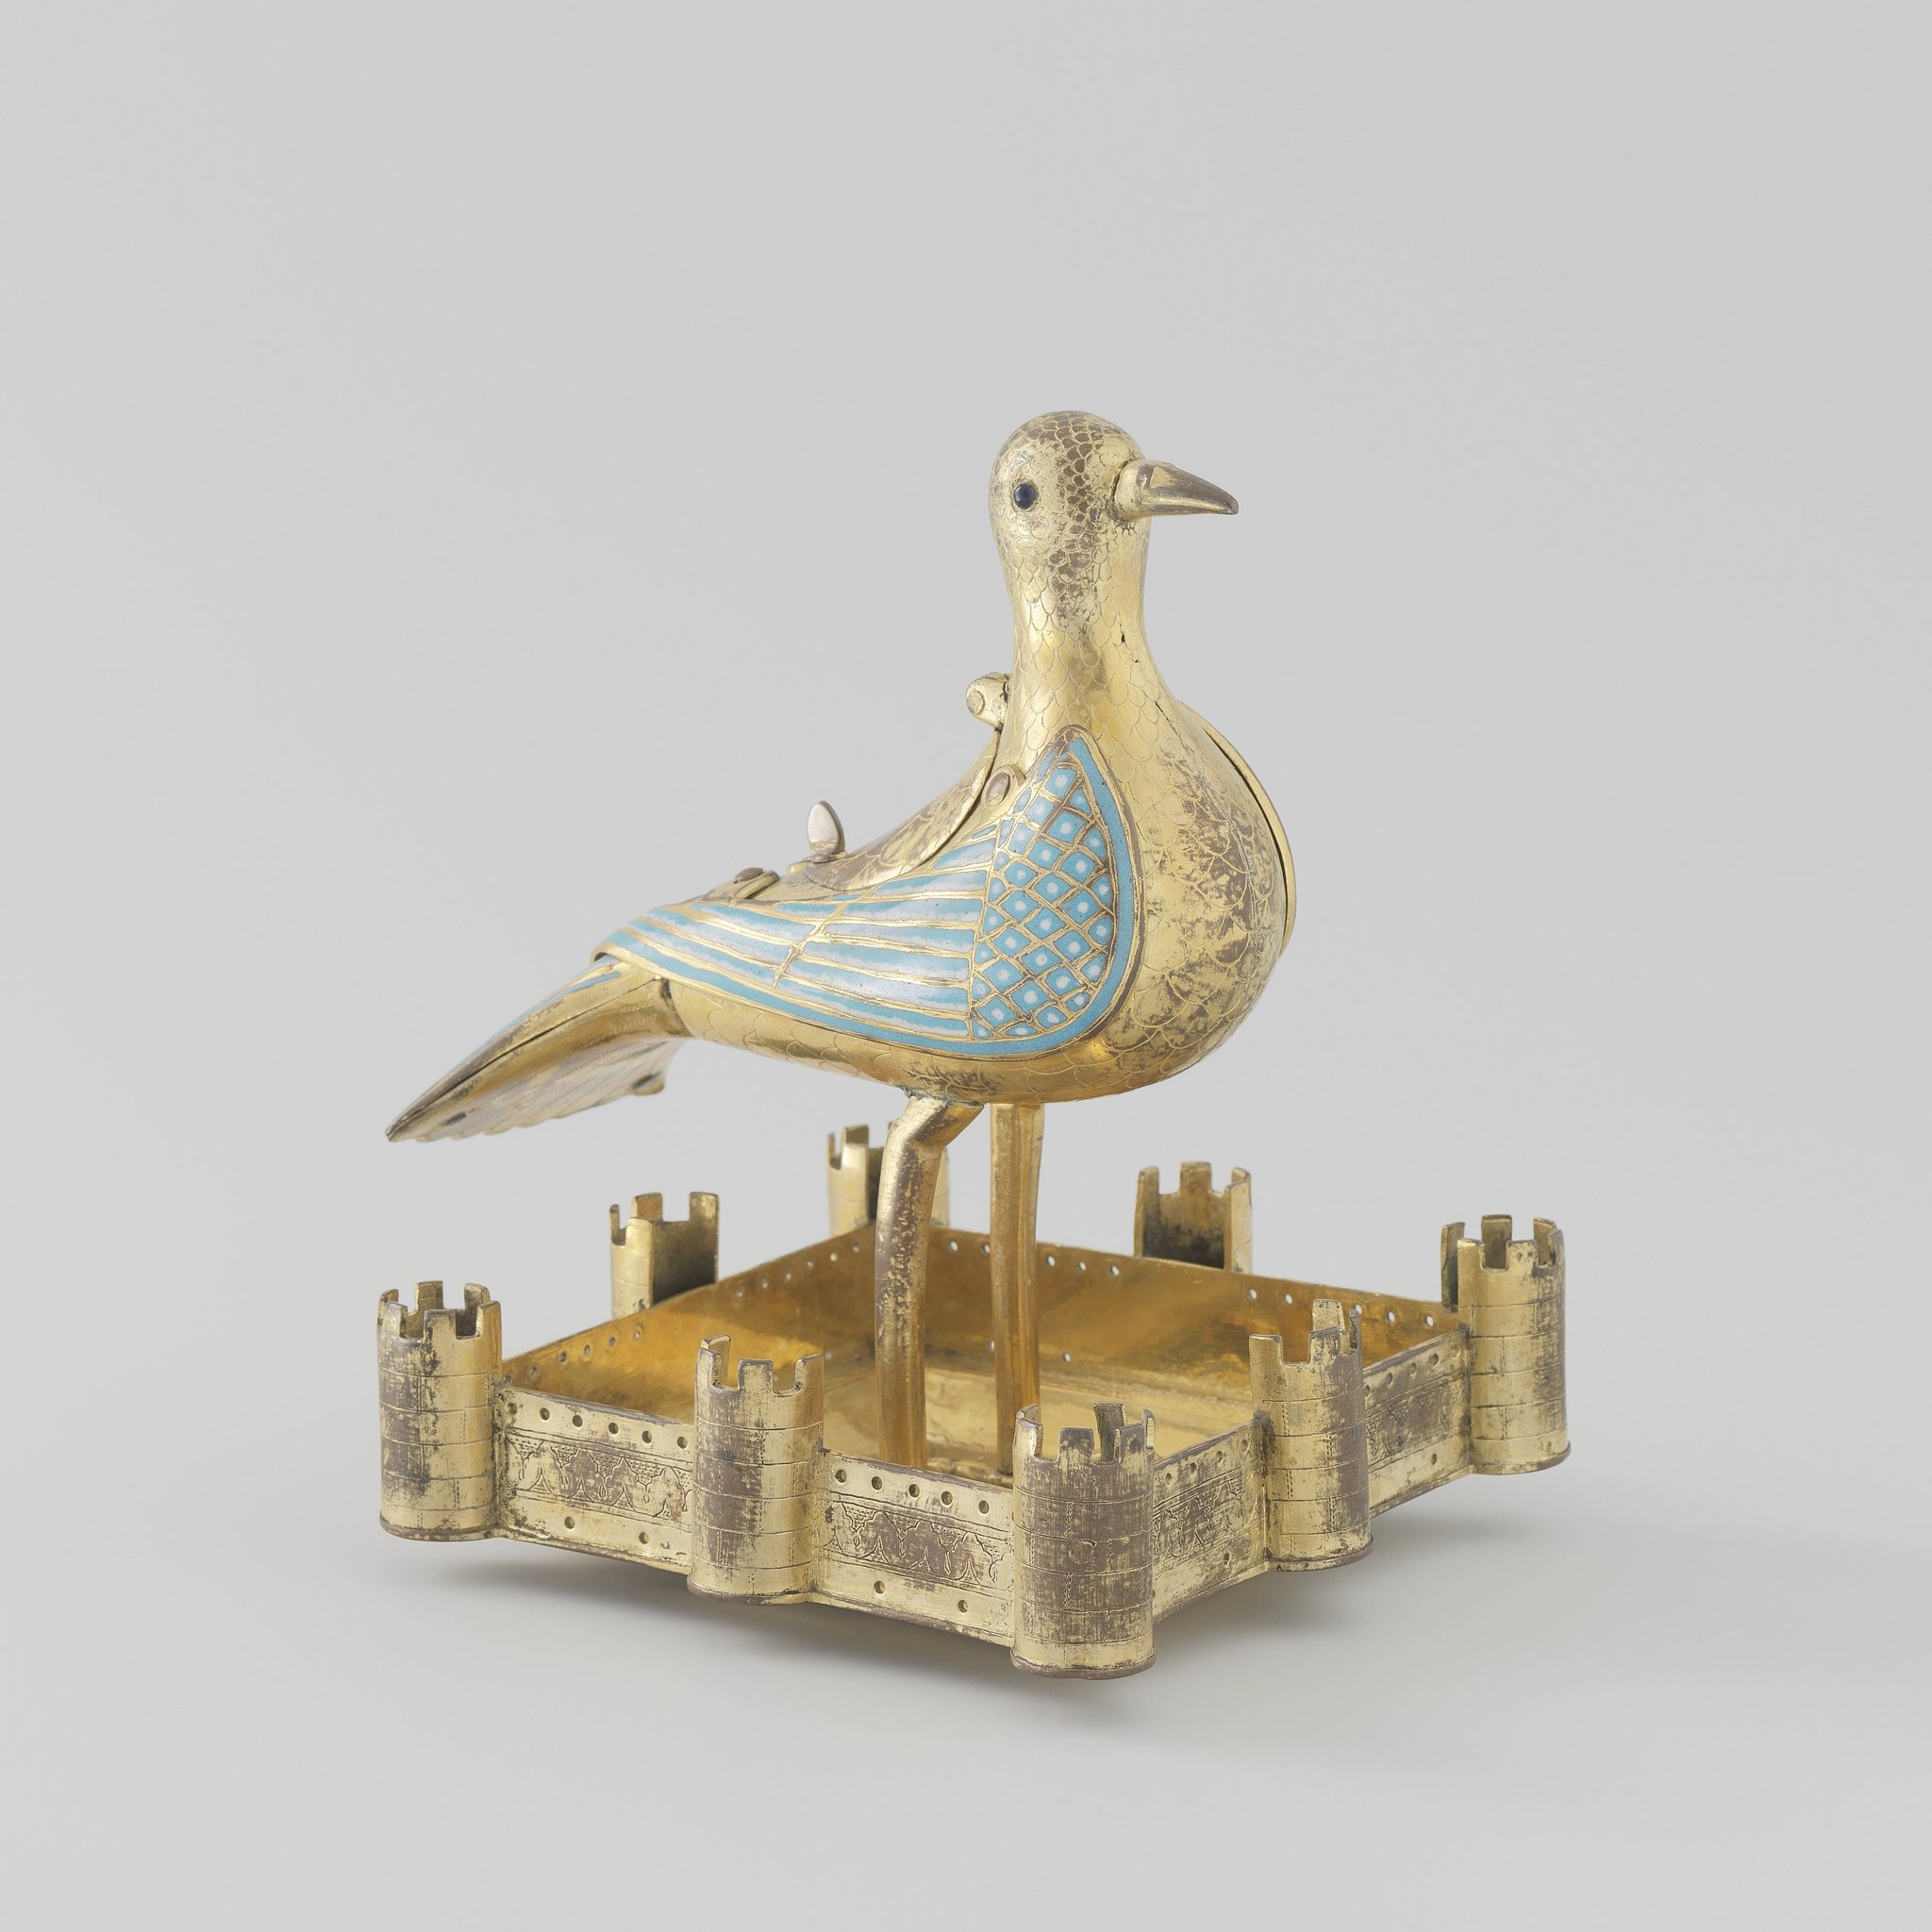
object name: figure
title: Dove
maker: Anonymous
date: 1225-1250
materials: copper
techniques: enamel, gilding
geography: limoges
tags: fortress, other birds: dove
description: Eucharistische duif van verguld koper en email champlevé. Geëmailleerd zijn de vleugels, de staart en het middenveld van de vierkante, door muren met acht torens omgeven schaal waarin de duif staat. Op de rug van de vogel een hartvormig deksel. Onder de bodem van de schaal een gegraveerd kruis.